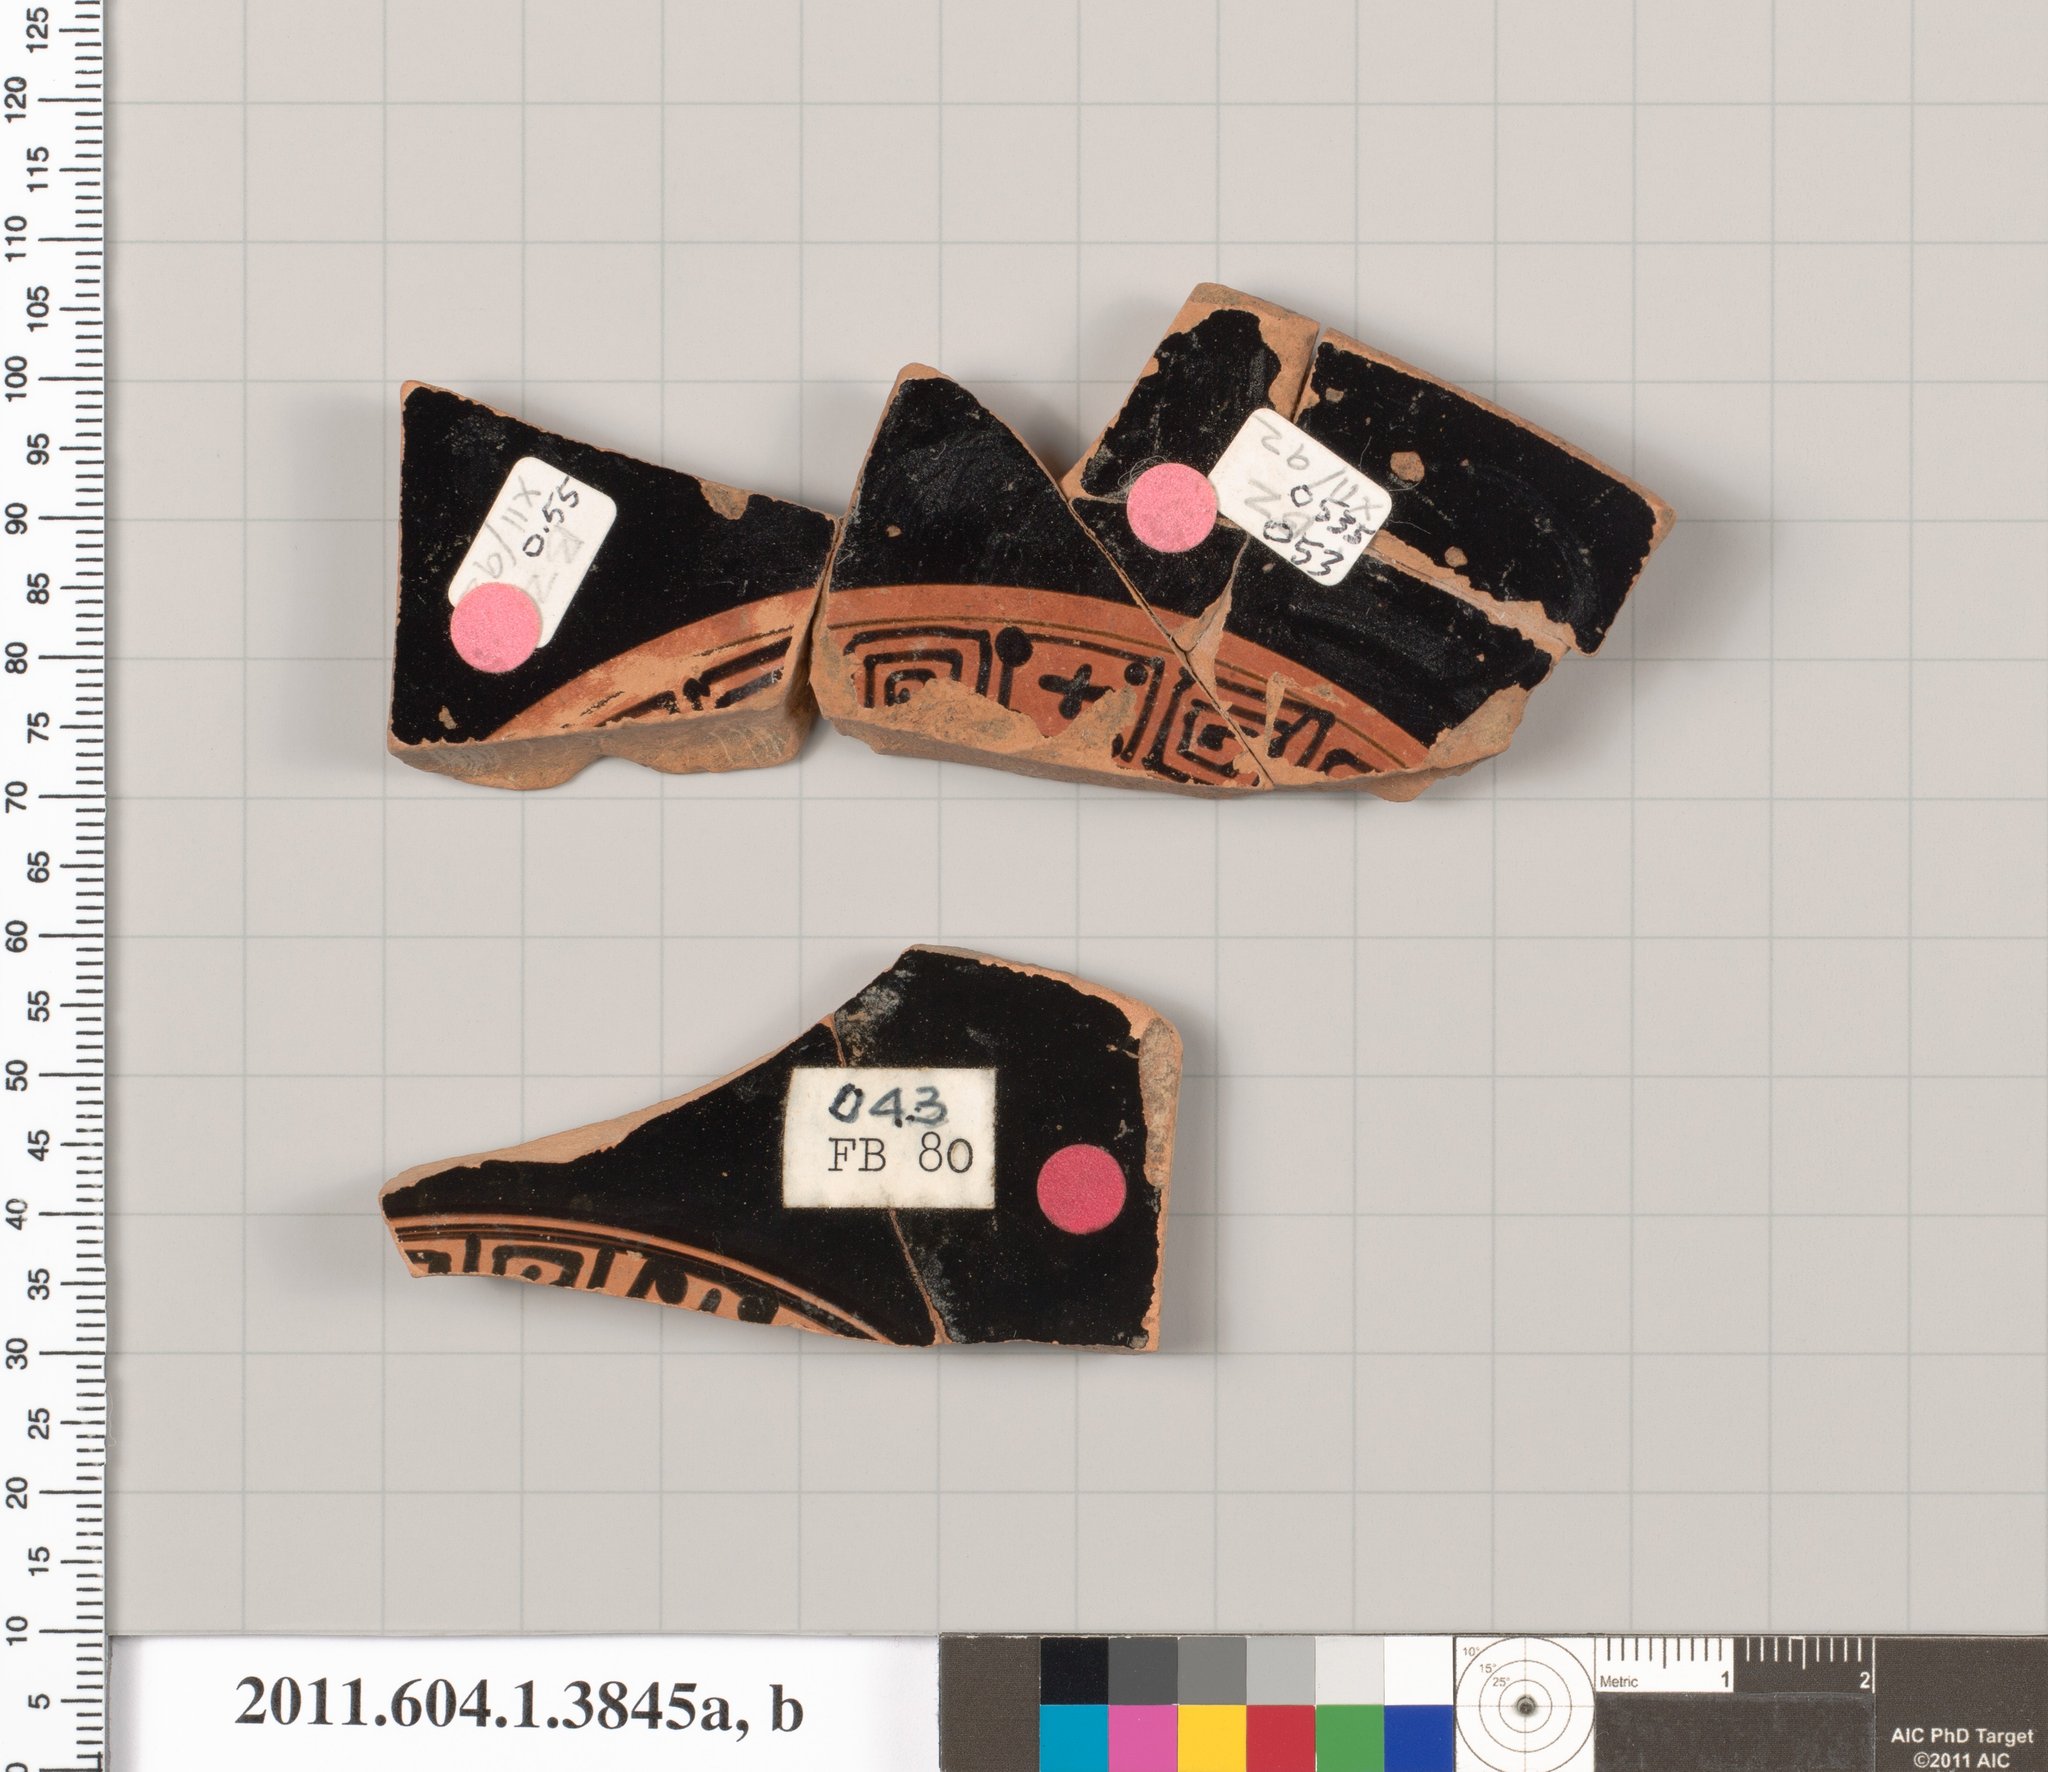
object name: kylix fragment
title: Terracotta fragments of kylikes (drinking cups)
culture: greek, attic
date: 460-440 BCE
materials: terracotta